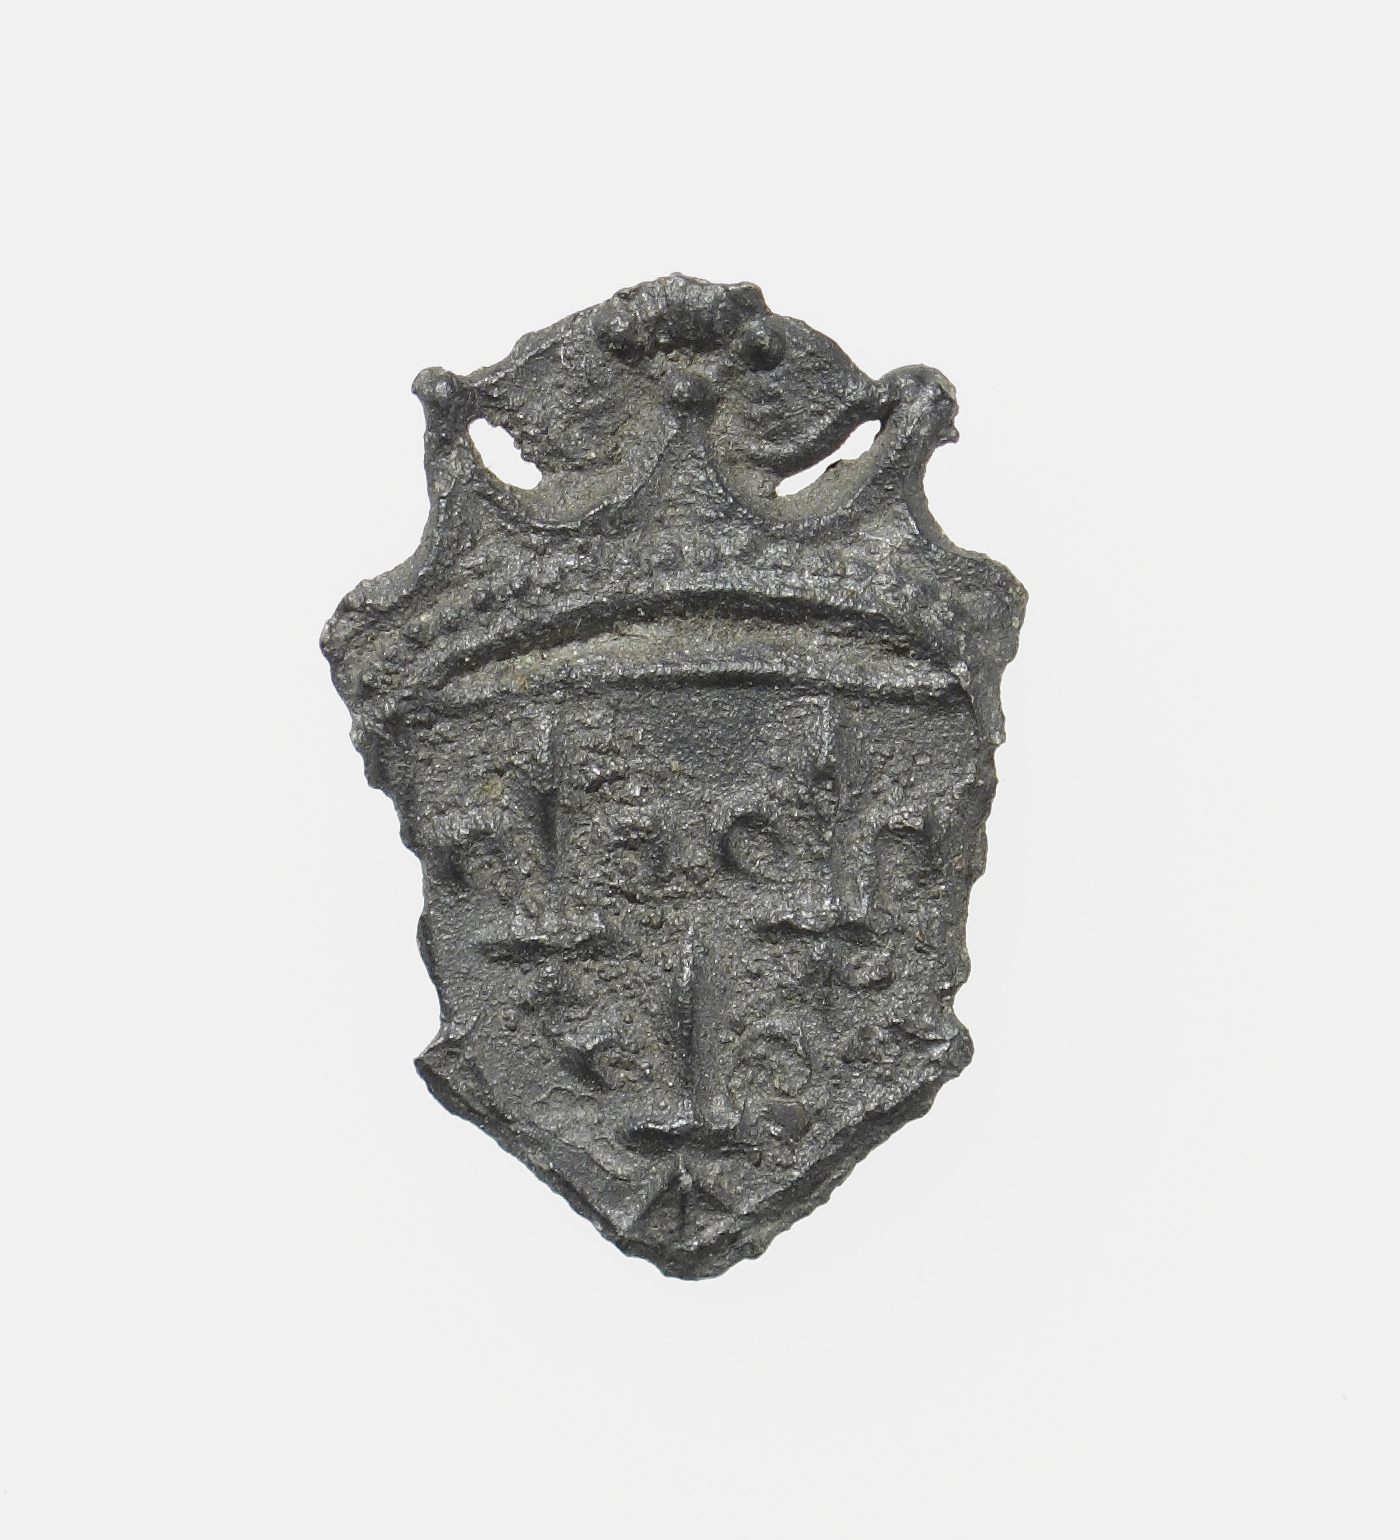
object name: pilgrim's badge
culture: french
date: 1301-1600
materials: lead